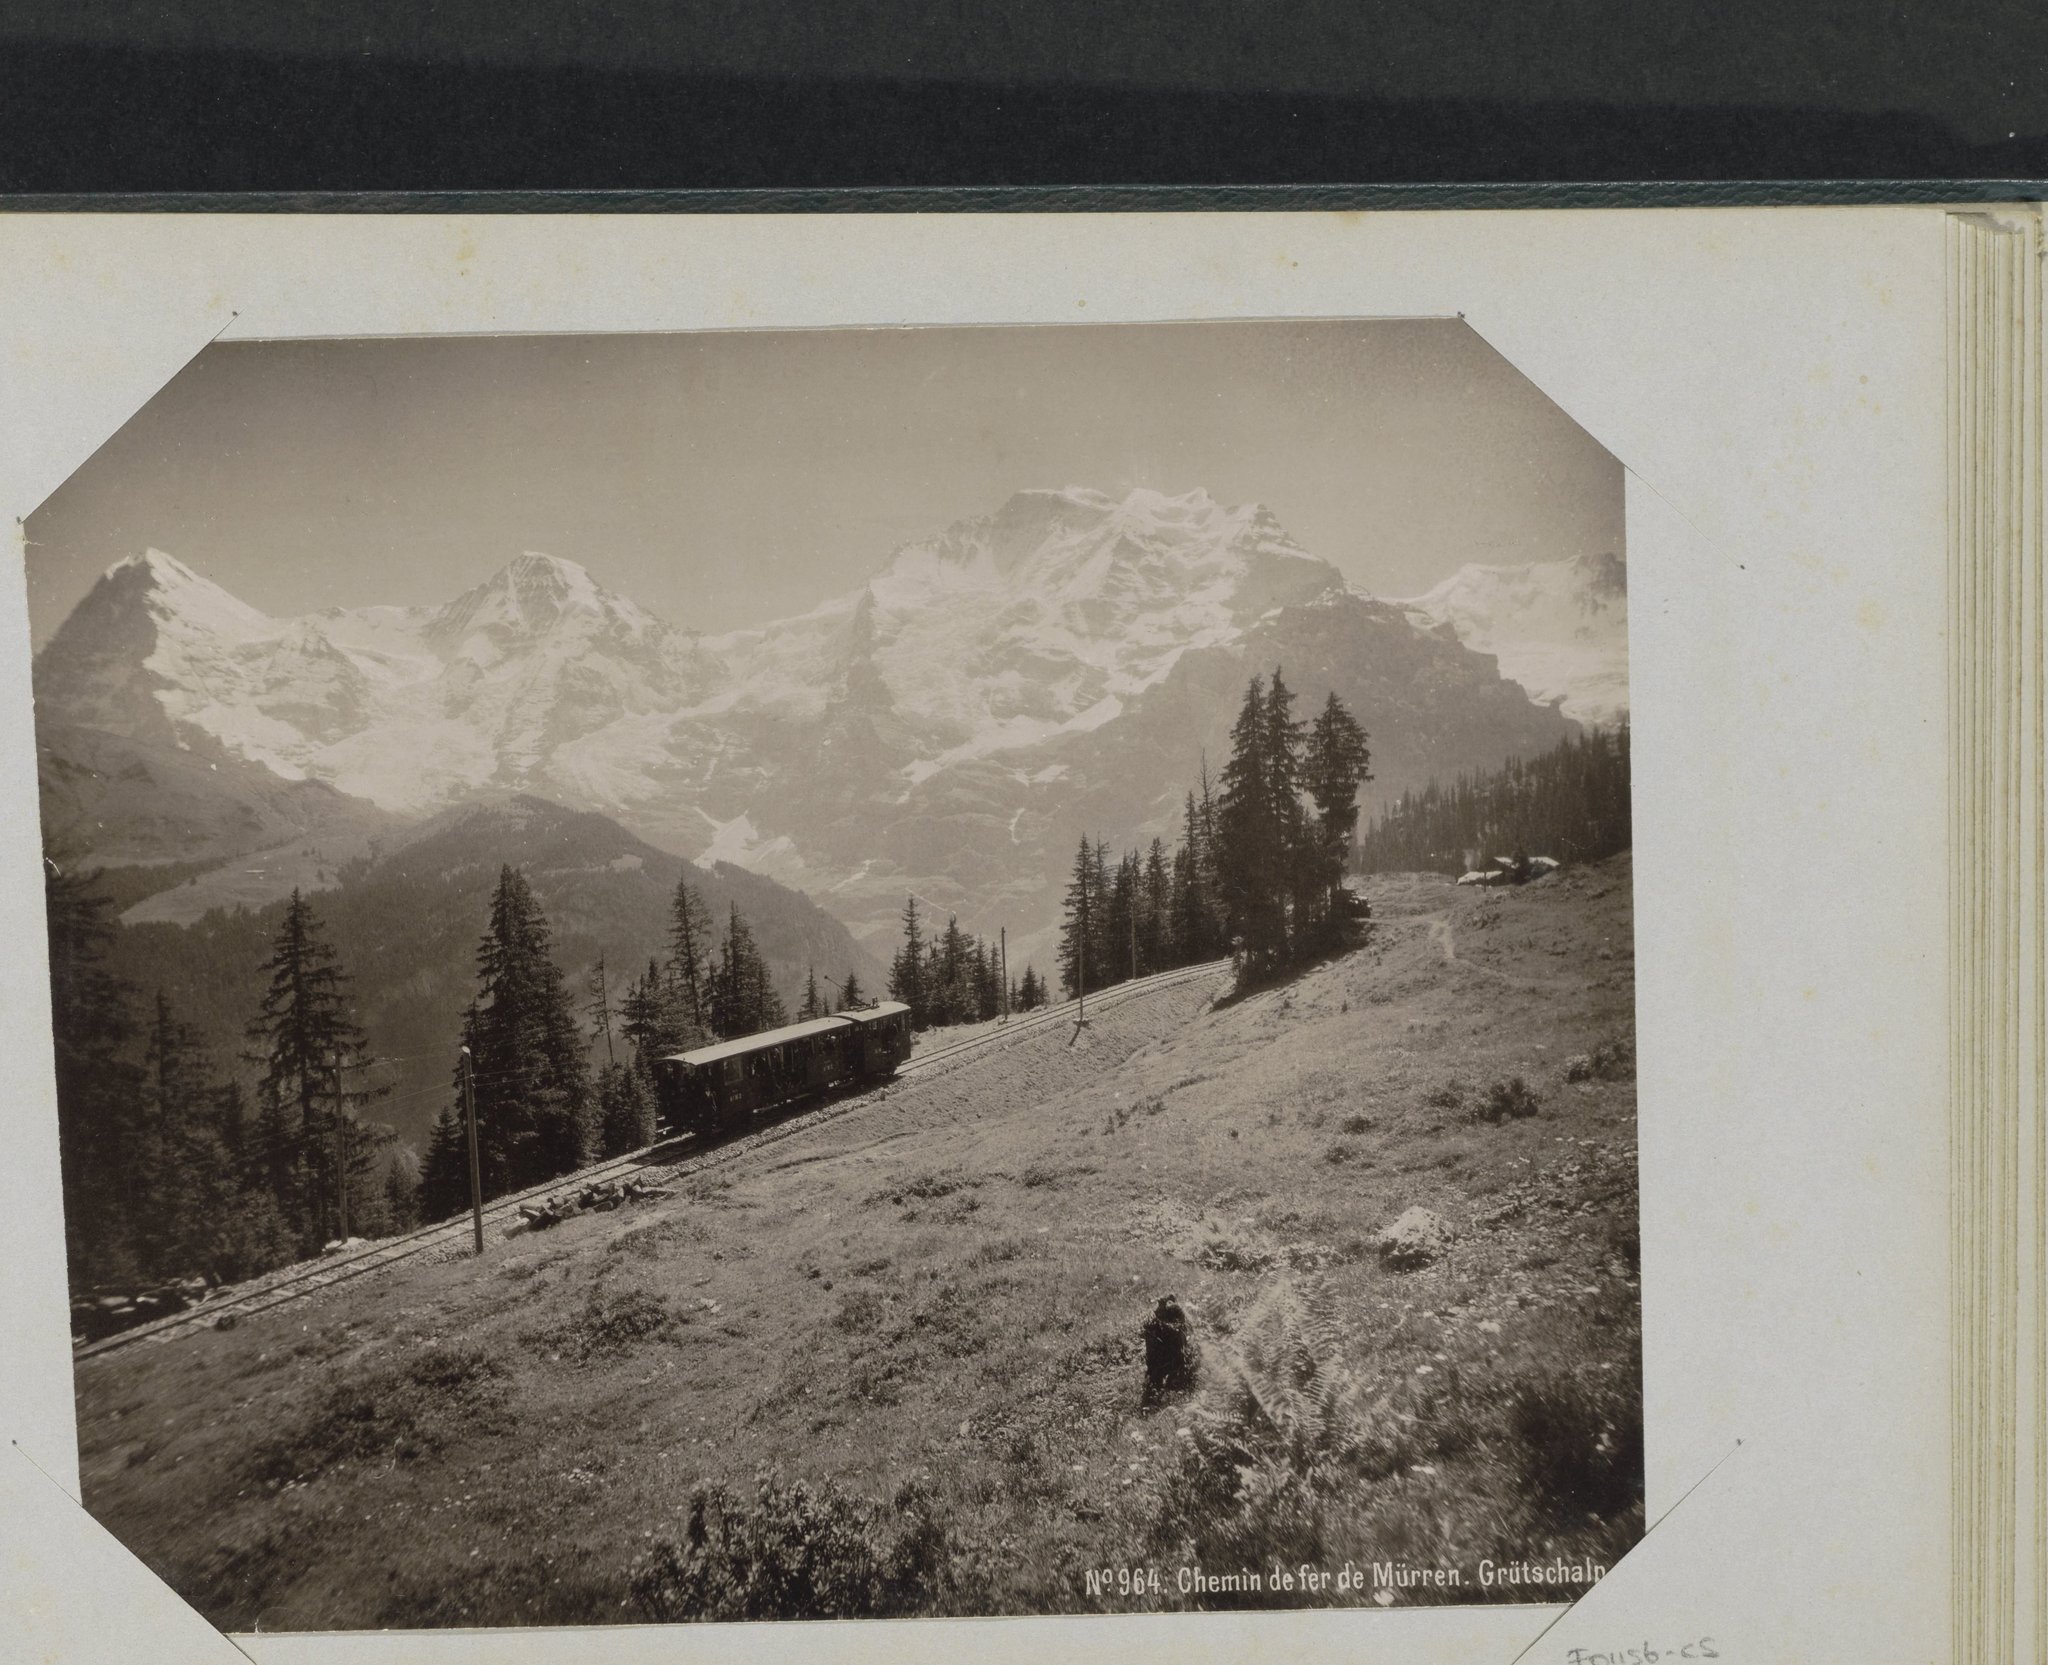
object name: album leaf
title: Treinstel op het spoor tussen Grutschalp en Mürren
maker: Anonymous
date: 1896-1897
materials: paper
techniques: photograph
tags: railway-coach, railway-carriage, wagon, mountain-range, snow peaks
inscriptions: inscription: ‘No. 964. Chemin de fer de Mürren. Grütschalp’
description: Deze prent maakt deel uit van een album.